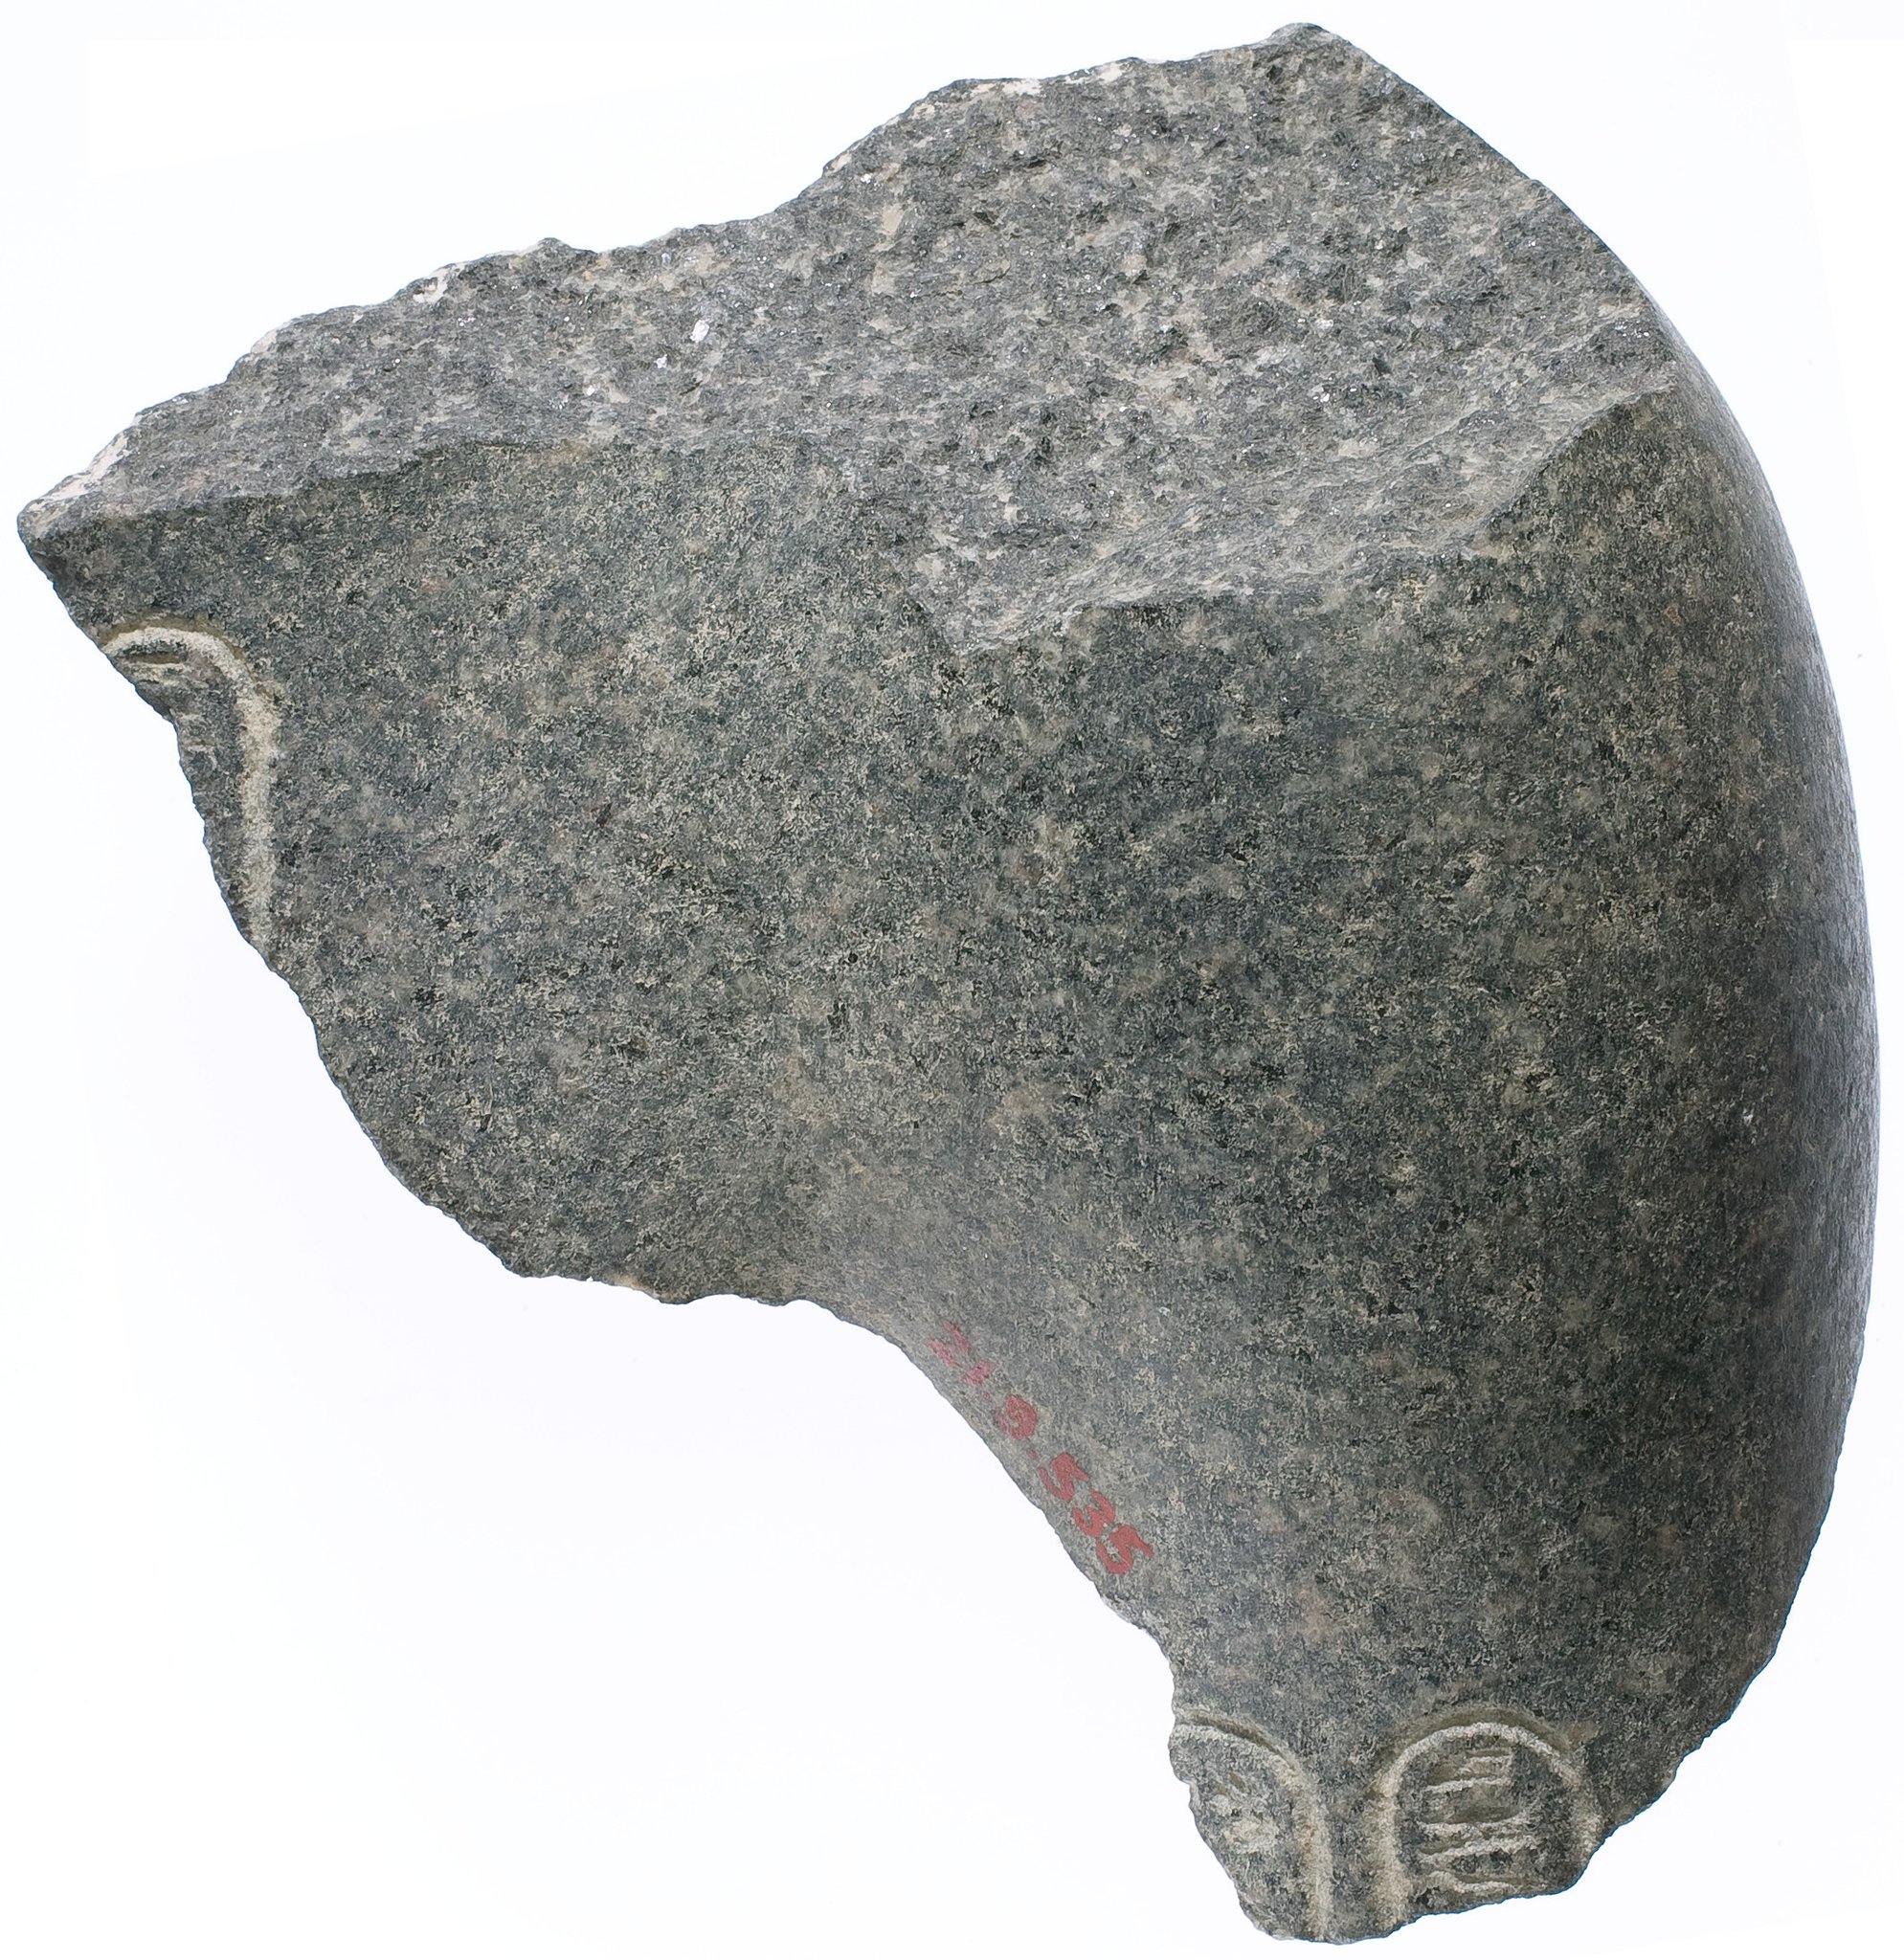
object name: left shoulder and chest, cartouch of aten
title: Left shoulder and chest with cartouches of Aten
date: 1353-1336 BCE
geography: egypt